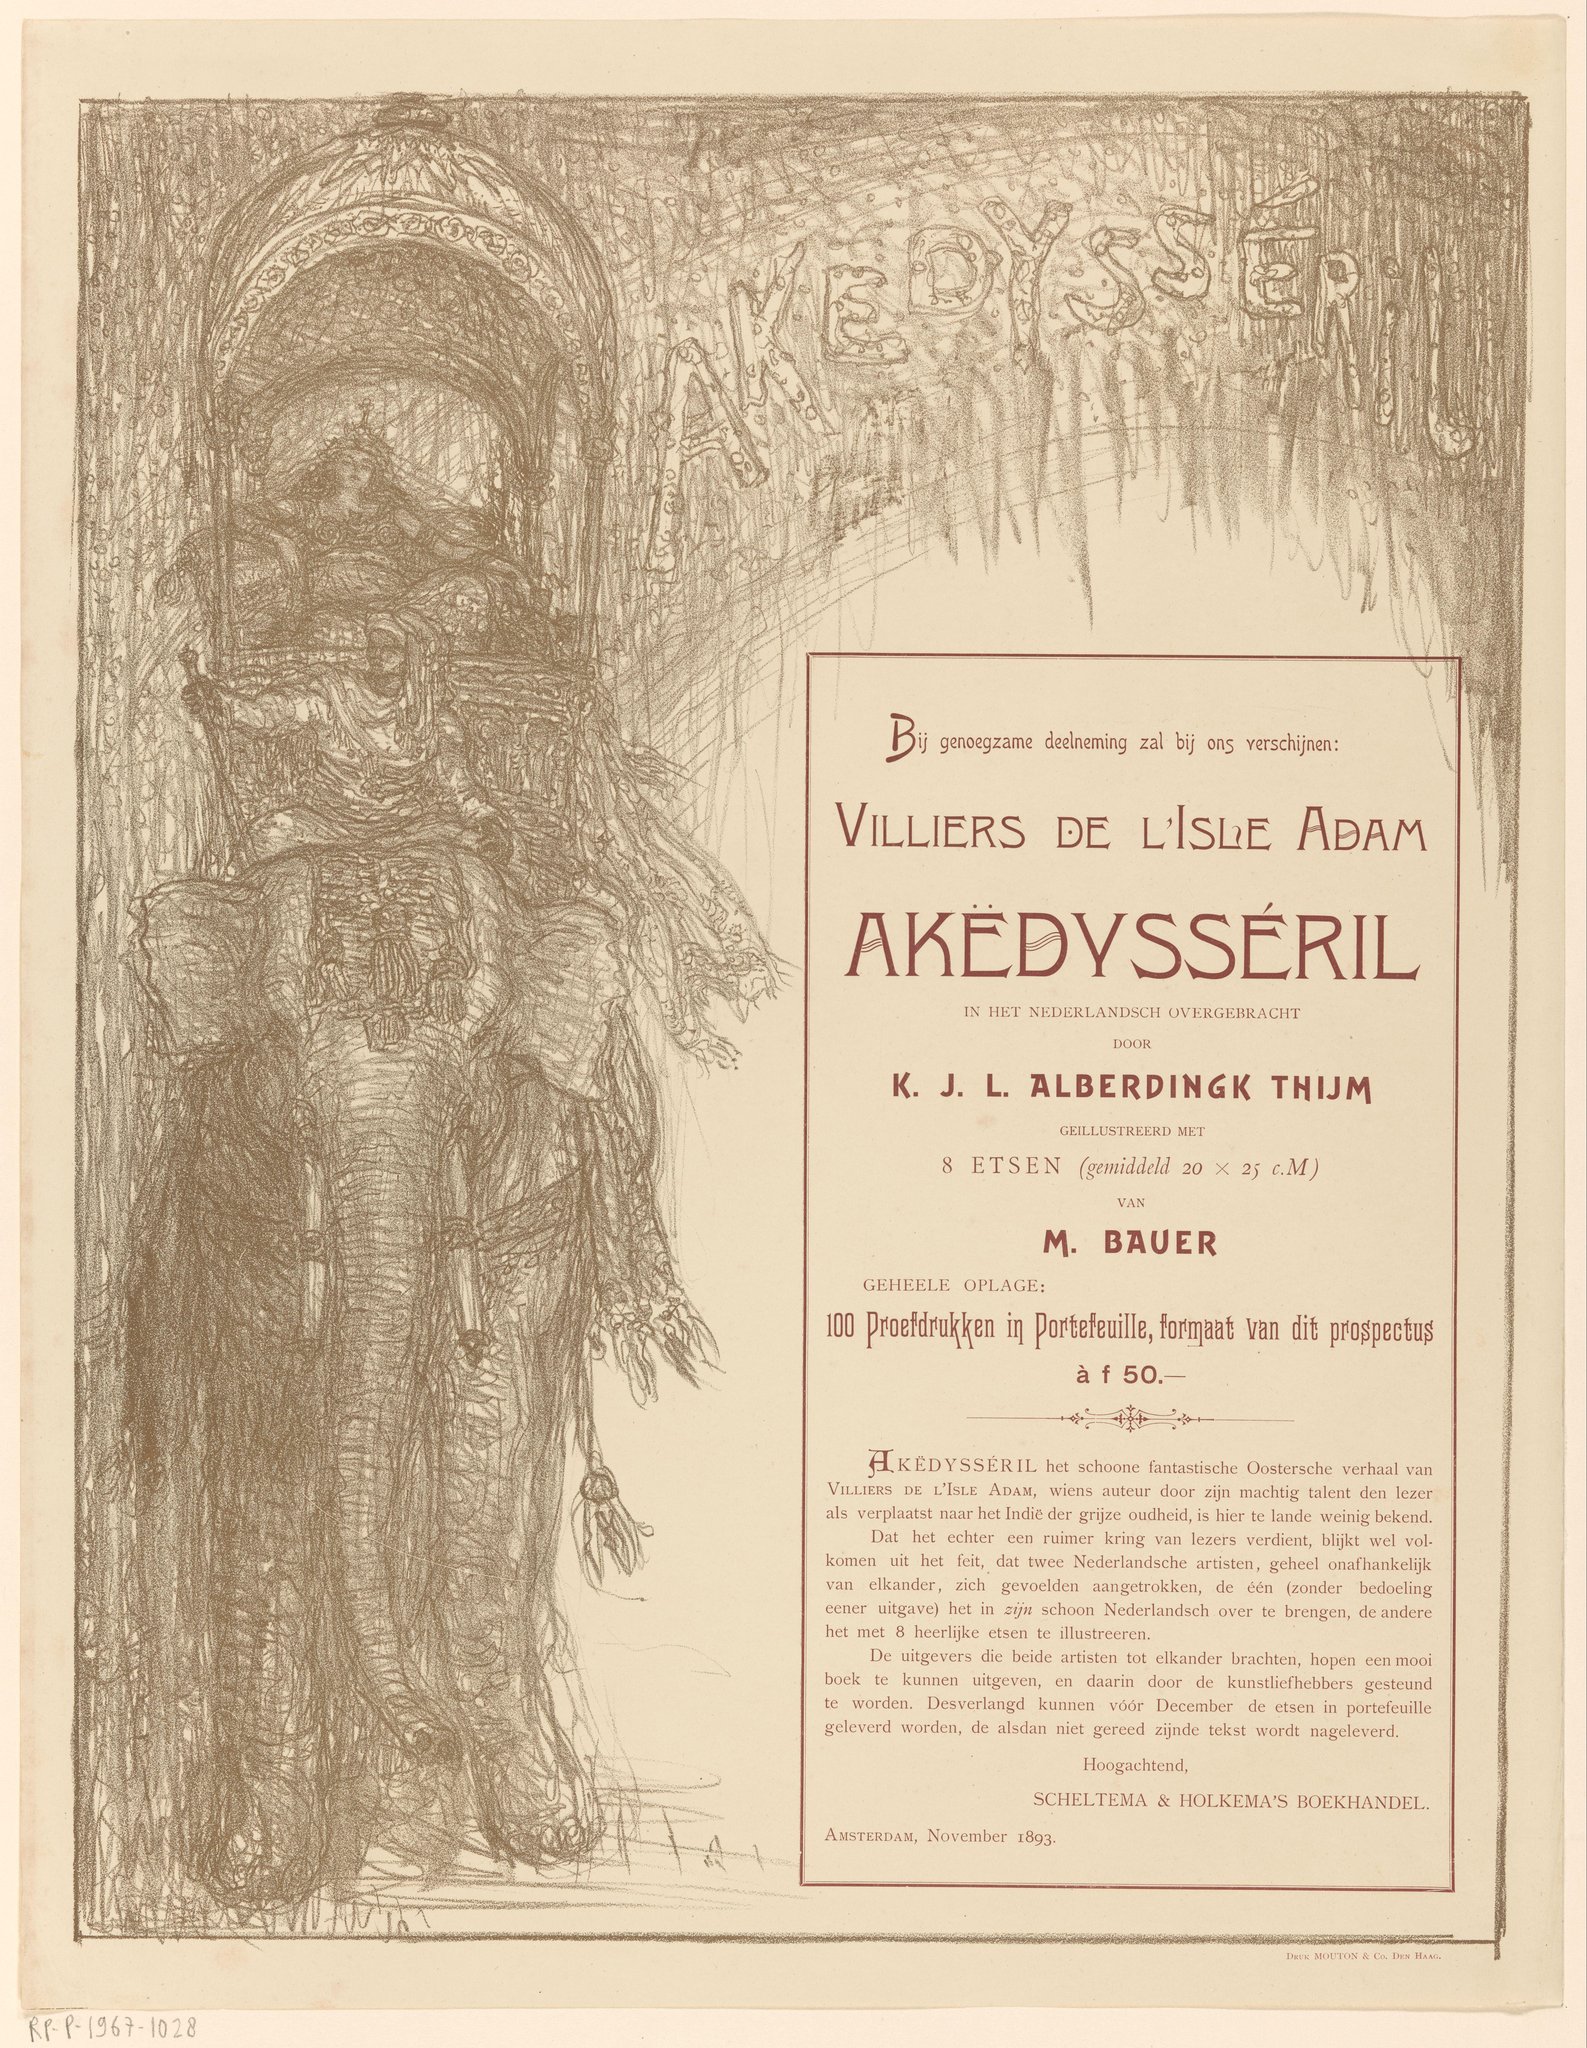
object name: print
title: Akedysséril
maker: marius bauer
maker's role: draughtsman, print maker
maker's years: 1867-1932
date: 1811-1893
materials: paper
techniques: lithograph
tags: riding on animal other than horse, ass, or mule, advertisement, notice, trunked animals: elephant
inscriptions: collector's mark: Lugt 2760, collector's mark: Lugt 2228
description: Bauer vervaardigde een serie van acht etsen als illustratie bij het prozagedicht Akëdysséril van Villiers de l'Isle Adam, dat door Lodewijk van Deyssel (pseudoniem van Karel Joan Lodewijk Alberdingk Thijm) naar het Nederlands vertaald werd. Dit is een affiche voor het prentenalbum waarin de etsen werden opgenomen. Een prinses gezeten op een olifant die door een man wordt bereden.